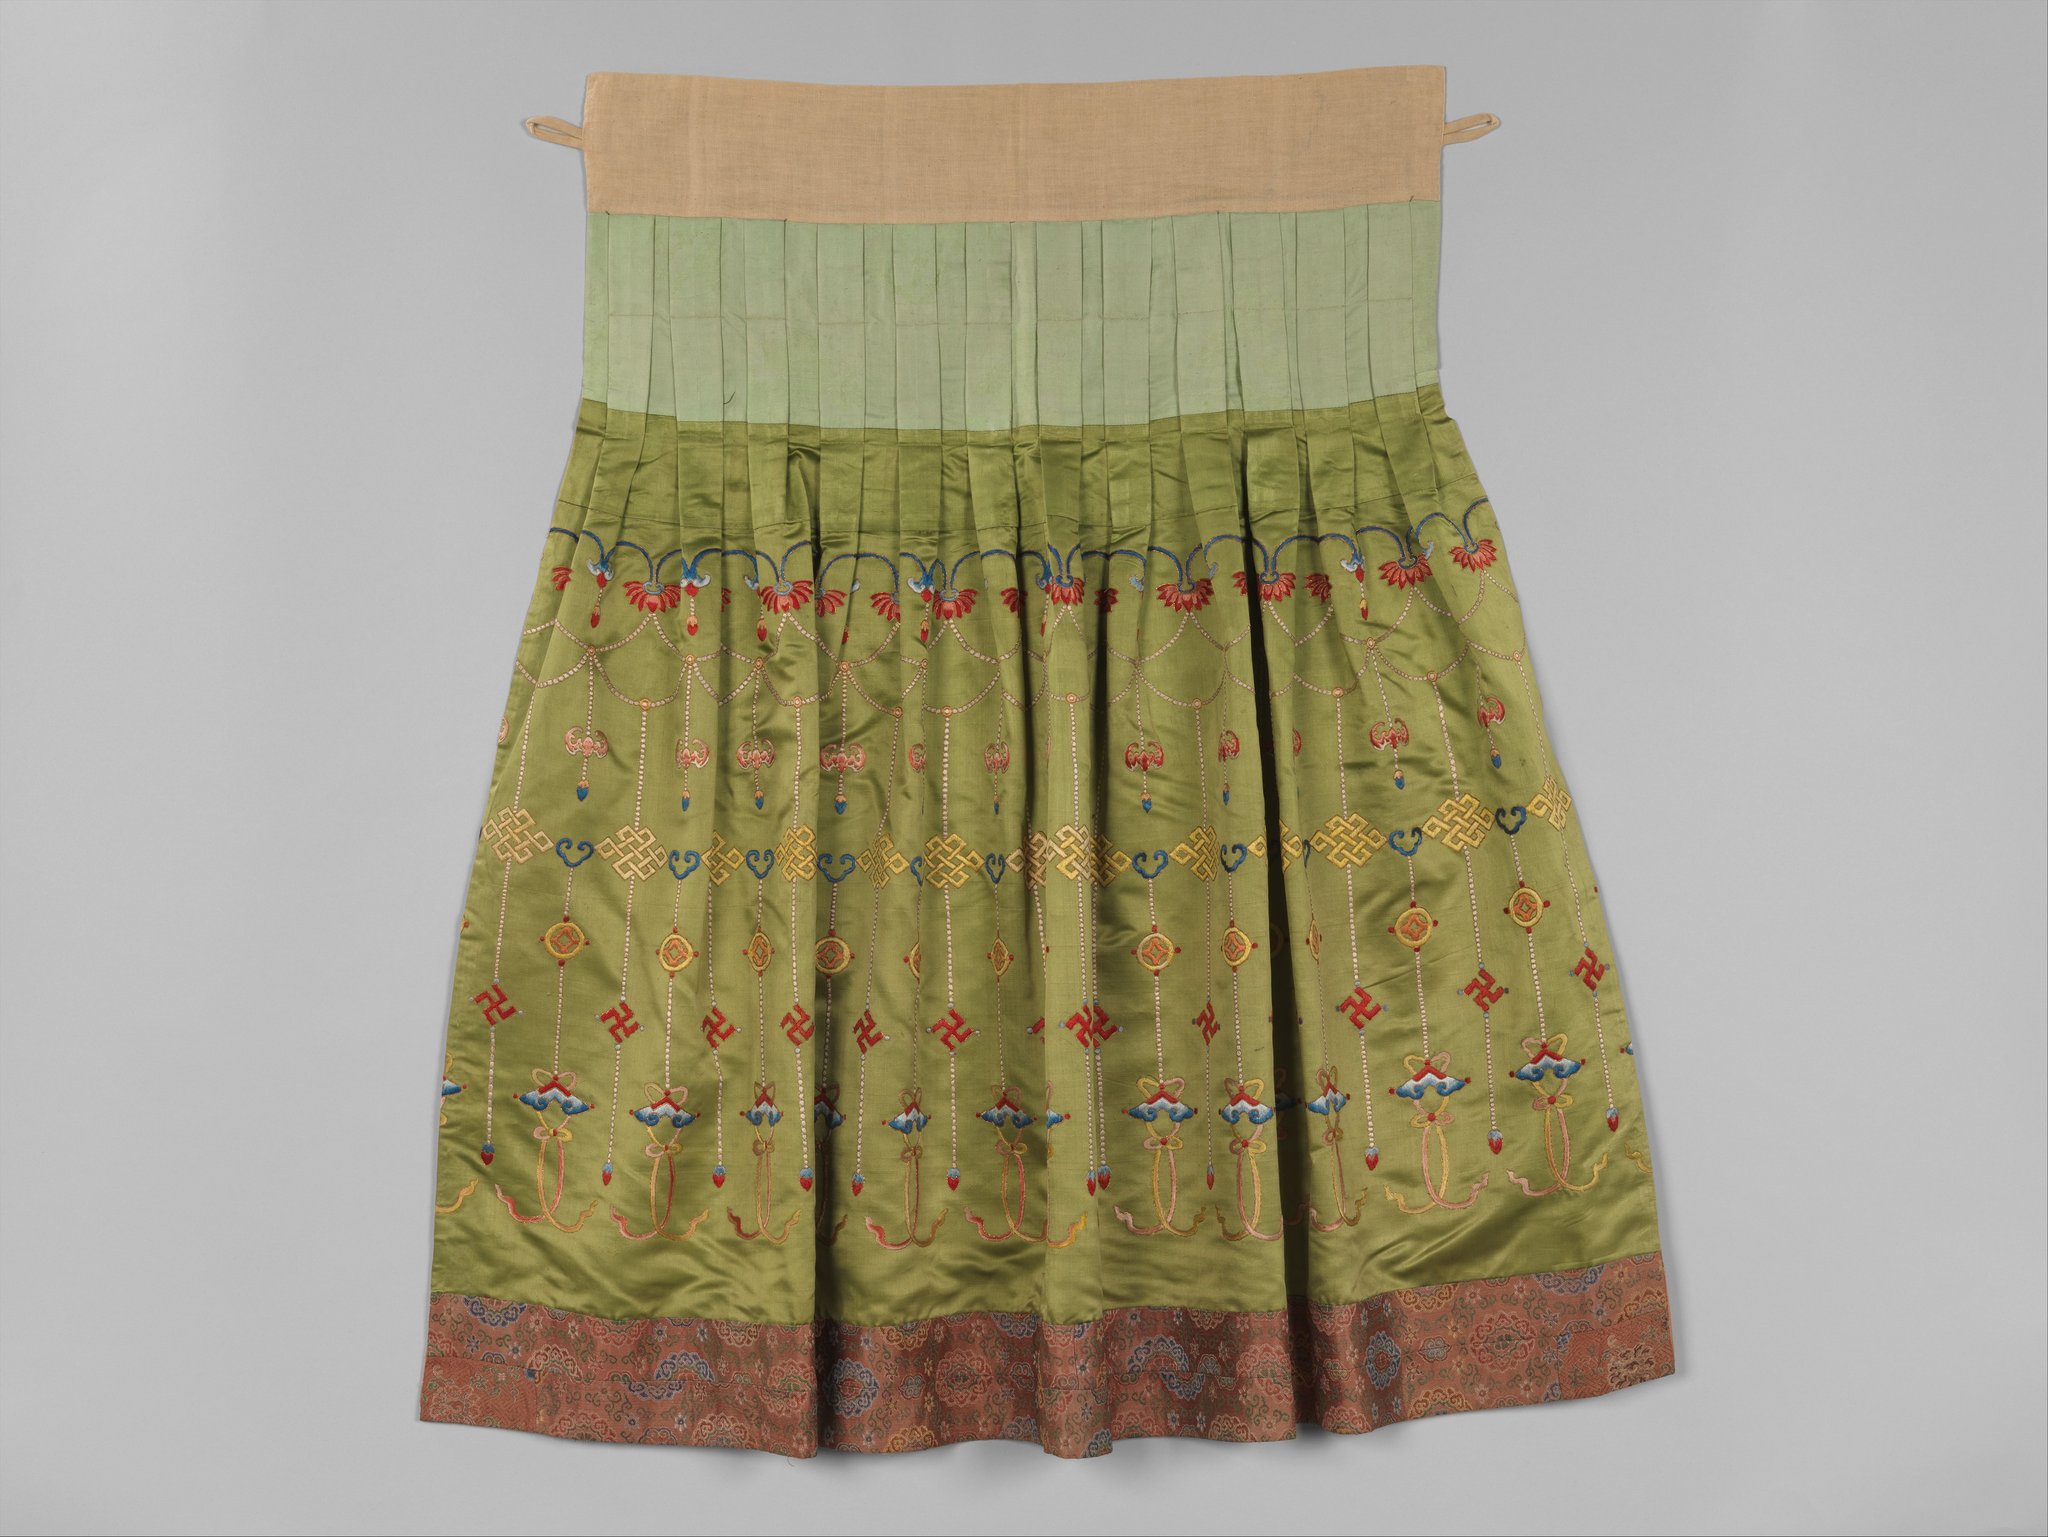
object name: skirt, imperial theatrical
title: Theatrical skirt with designs from Buddhist jewelry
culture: chinese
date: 1701-1800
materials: metal thread, silk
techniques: brocade, embroidery